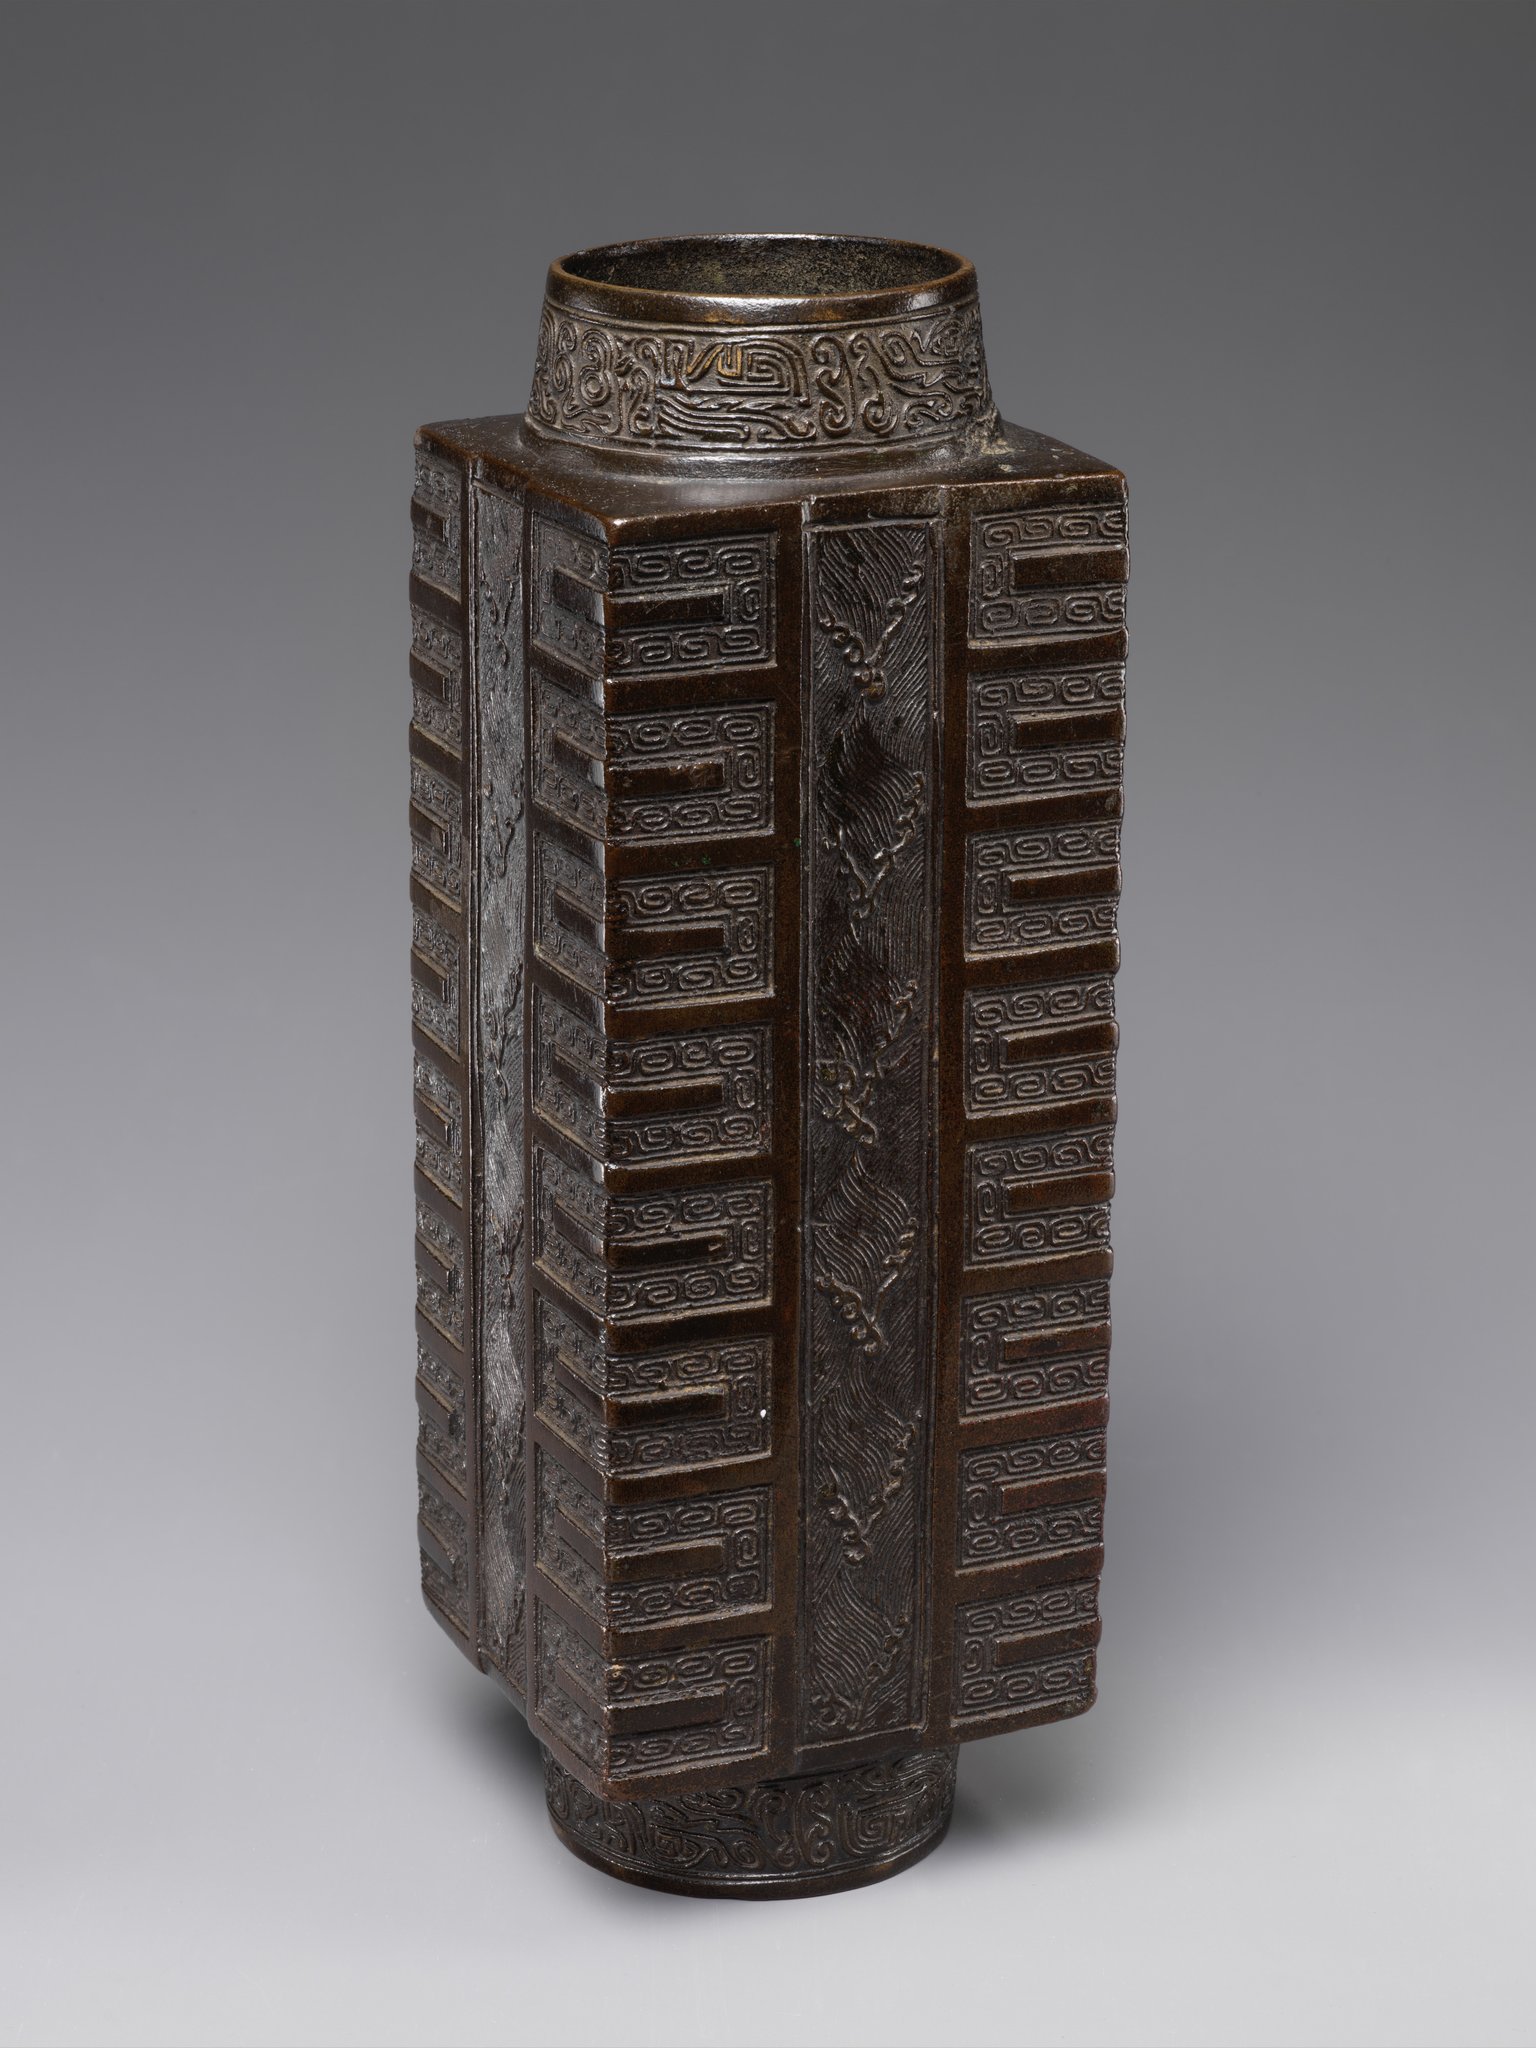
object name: vase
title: Quadrangular vase in the shape of a Neolithic cong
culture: chinese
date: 1201-1300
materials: copper alloy